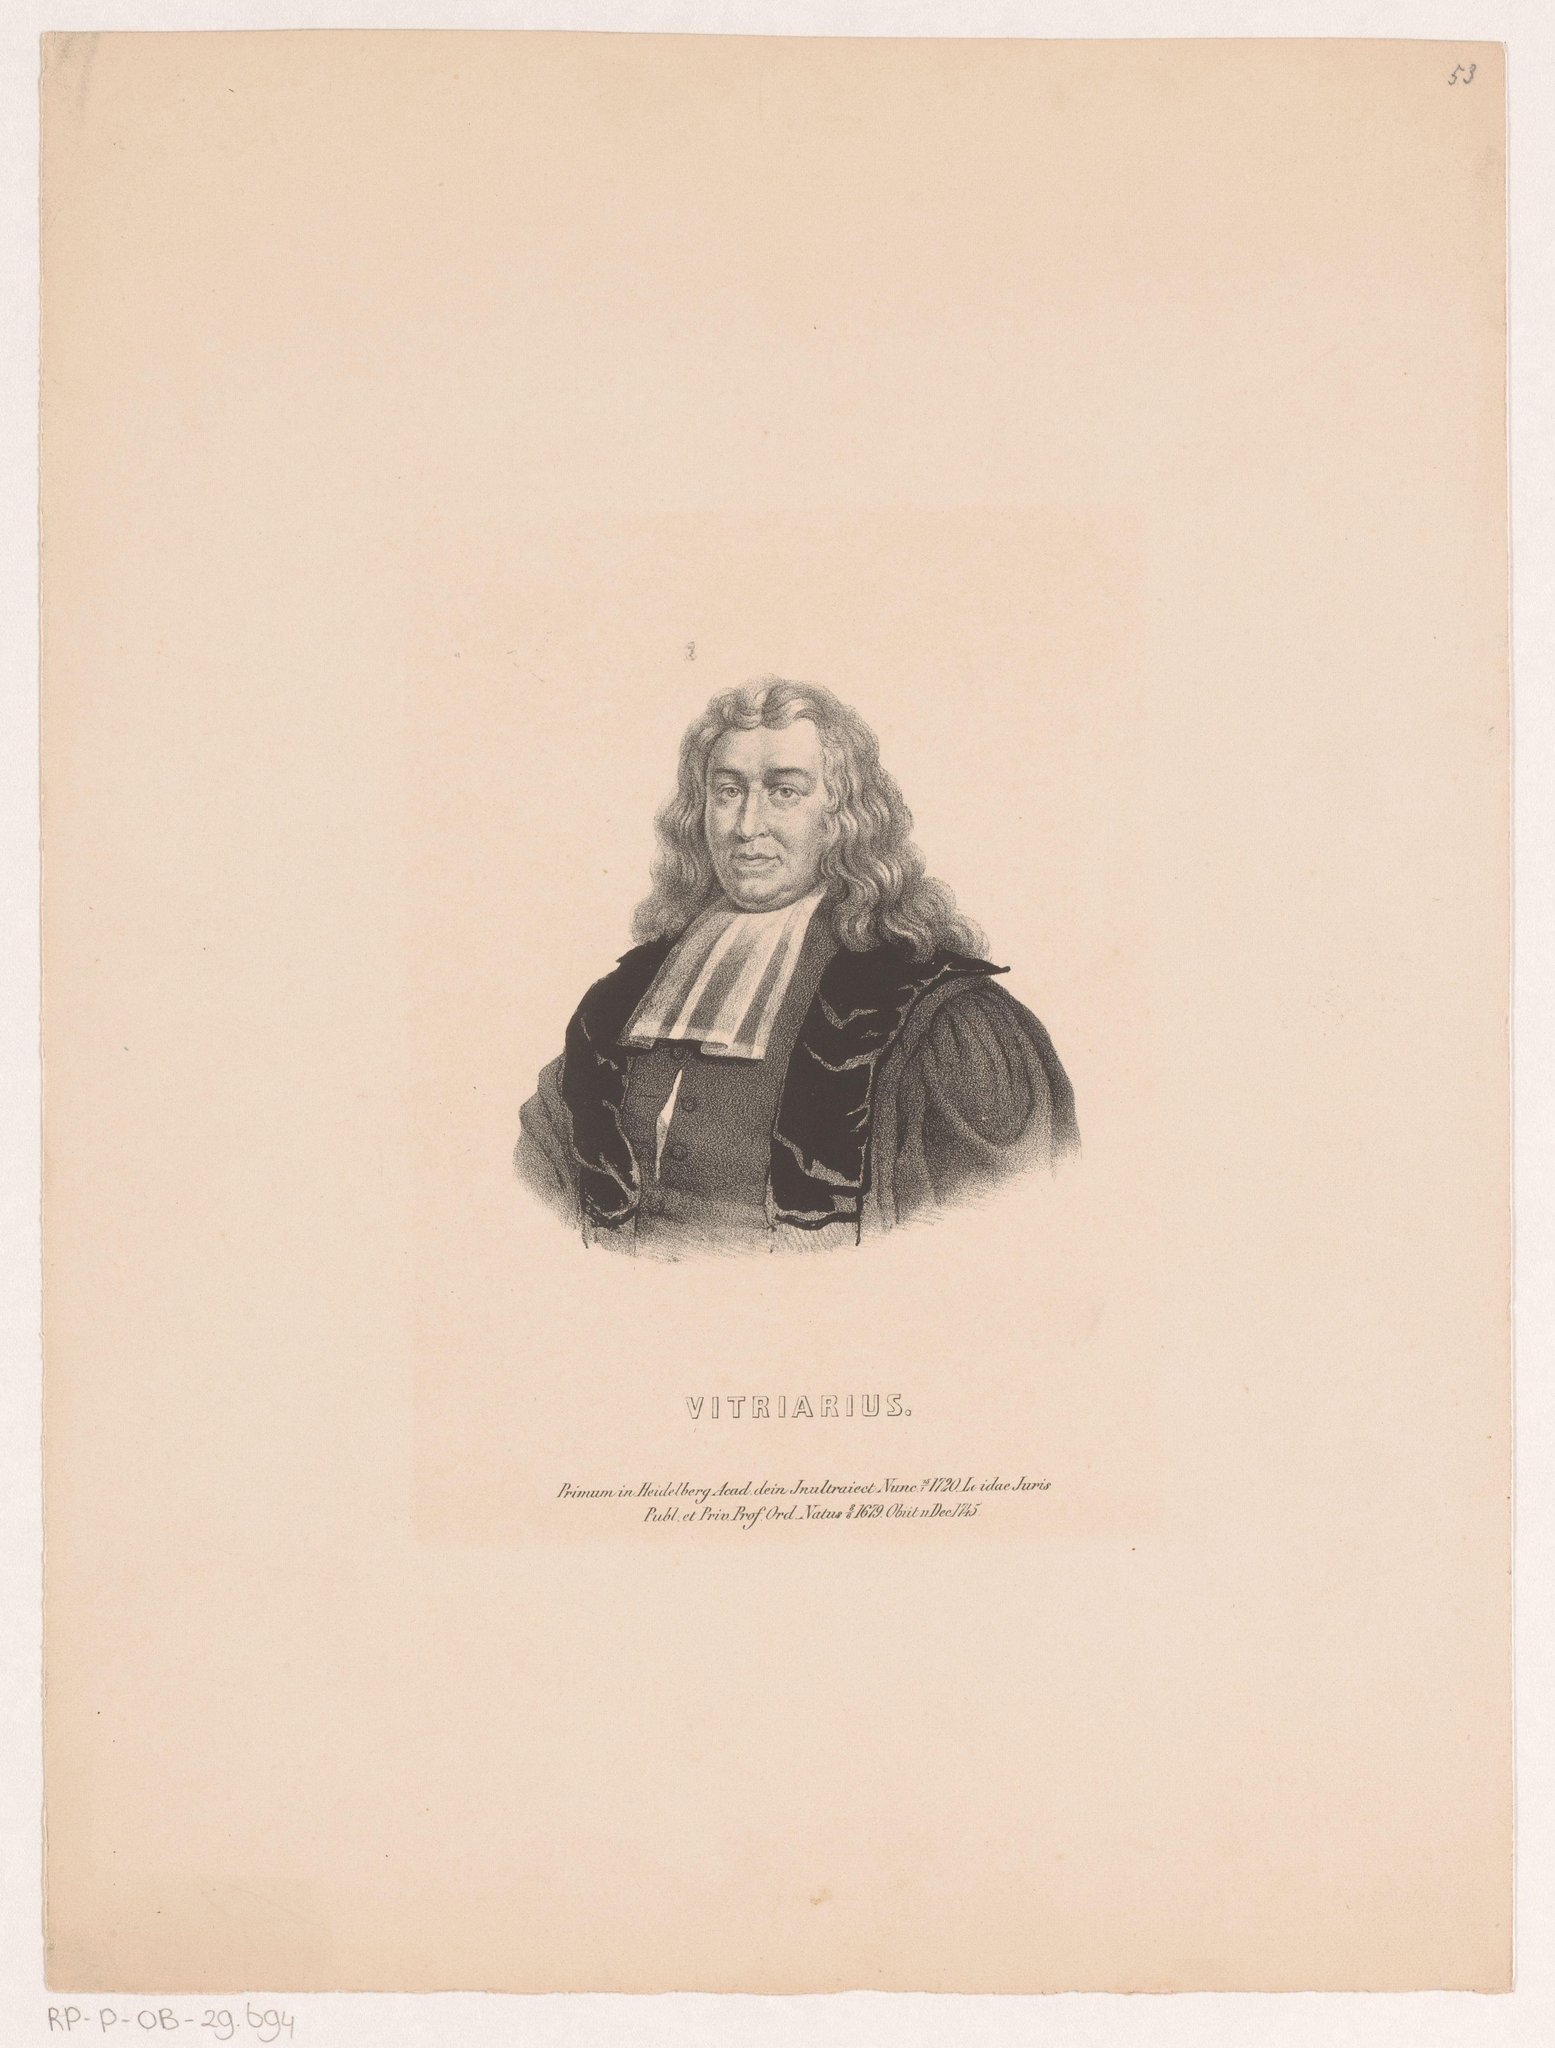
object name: print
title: Portret van Johannes Jacobus Vitriarius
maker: leendert springer (i)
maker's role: draughtsman, painter, print maker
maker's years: 1789-1871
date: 1850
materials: paper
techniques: lithograph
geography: leiden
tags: leiden, historical persons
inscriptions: collector's mark: Lugt 2228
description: Prent uit: Springer, Leendert. Galerij van hoogleeraren aan de Hoogeschool te Leijden, naar de oorspronkelijke afbeeldsels op de Senaat-zaal aldaar berustende. Leiden: Springer, Leendert., s.a. [circa 1850].